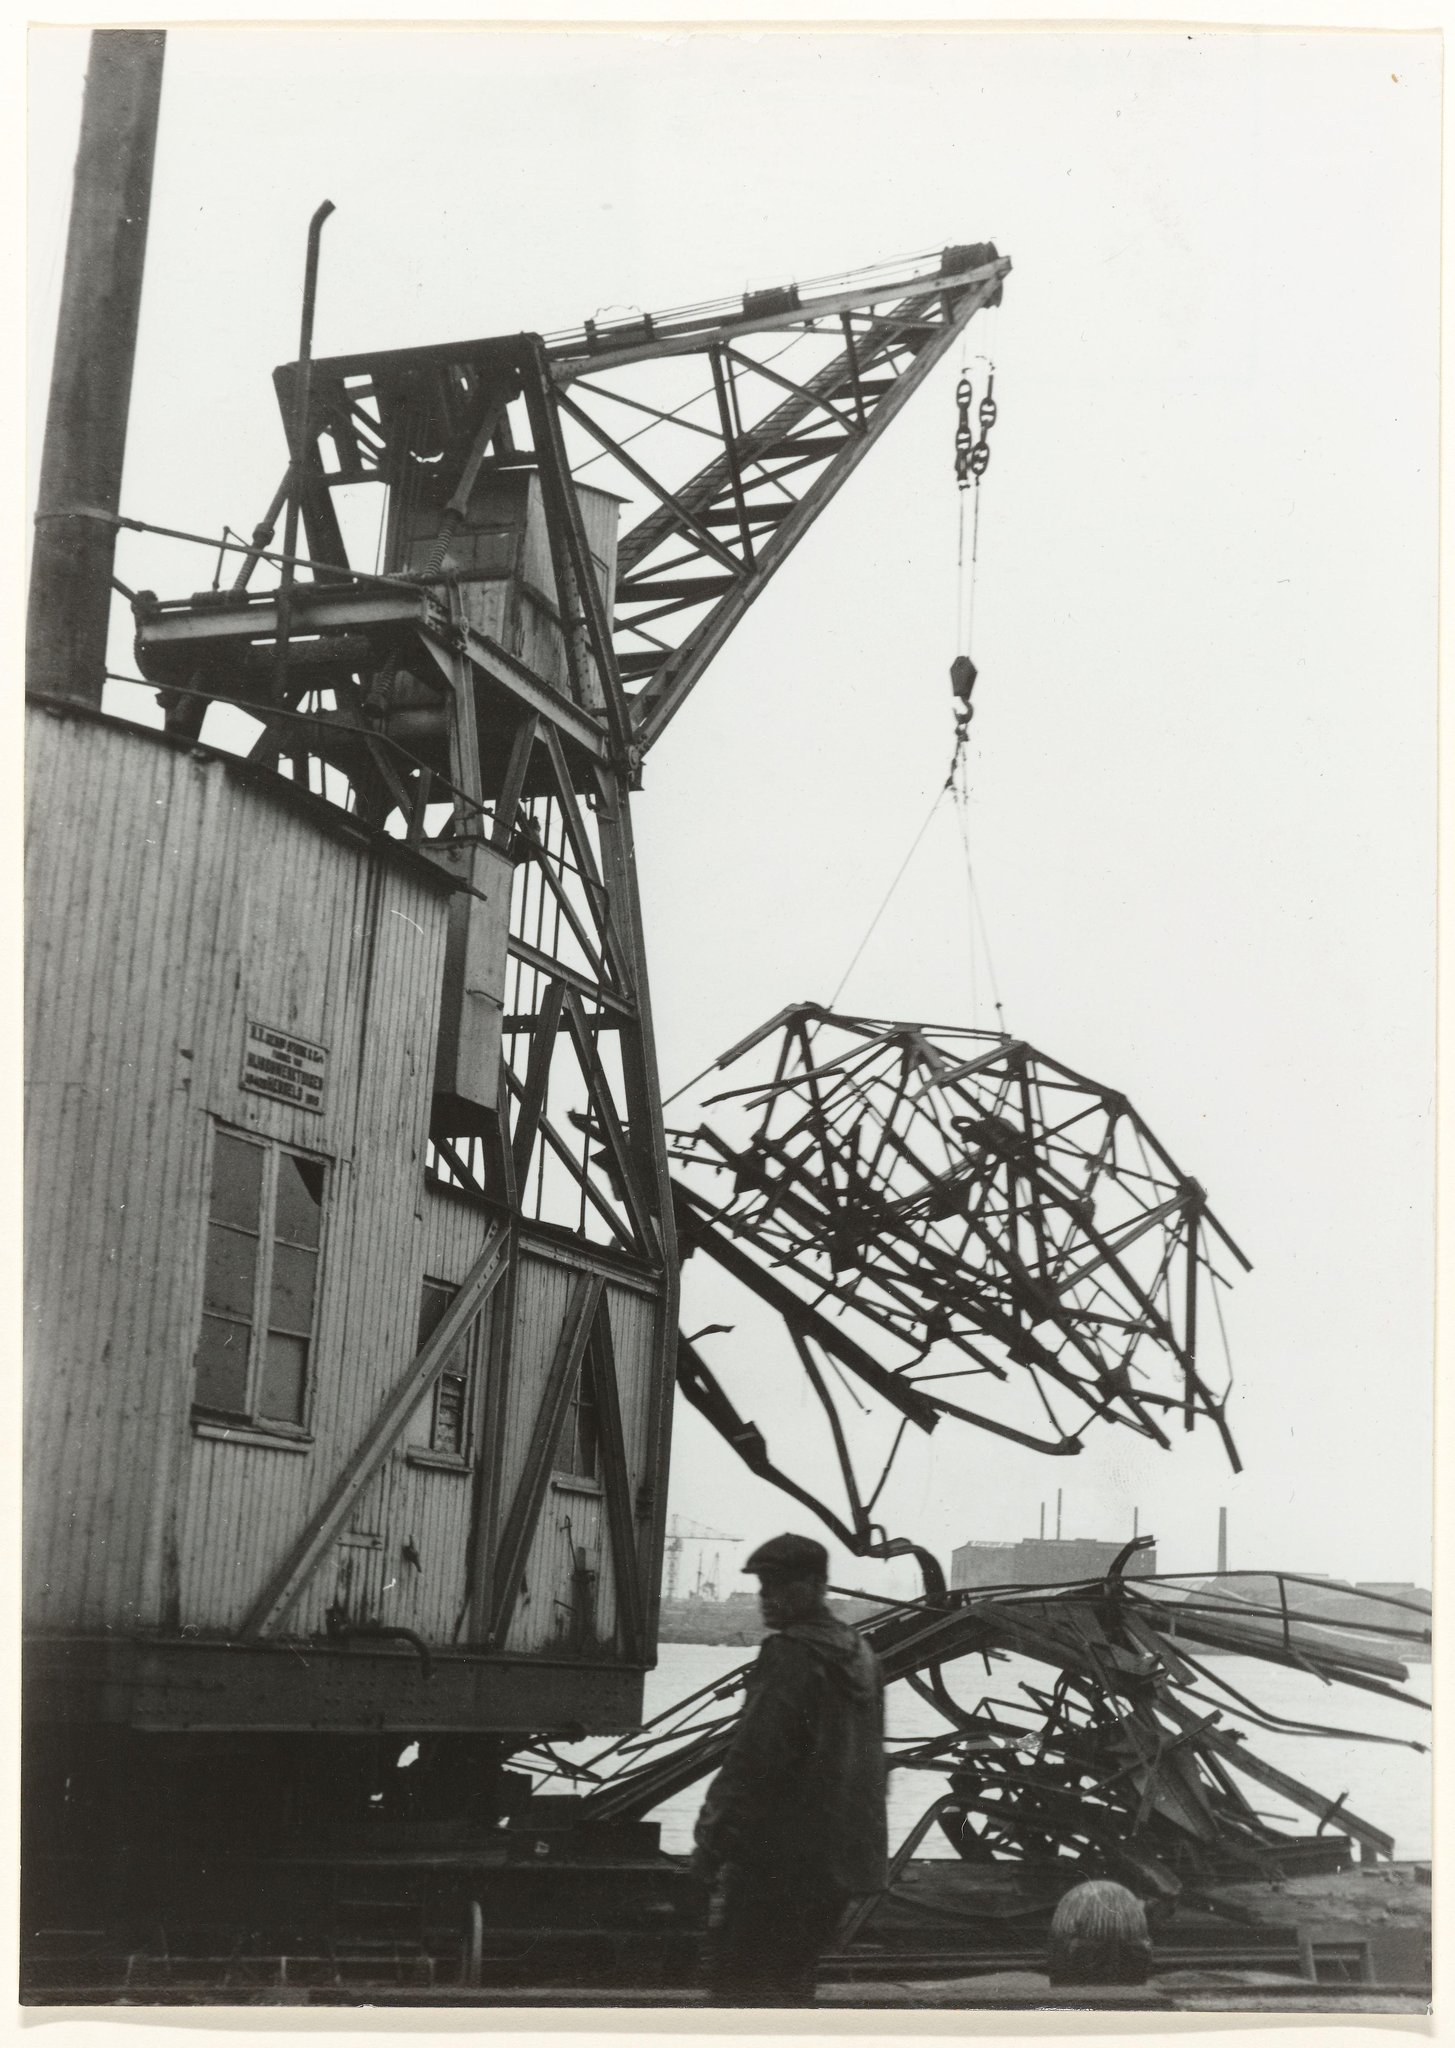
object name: photograph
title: Wederopbouw van de Amsterdamse haven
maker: charles breijer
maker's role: fotograaf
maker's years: 1914-2011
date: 1910-1945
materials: photographic support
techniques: photography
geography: amsterdam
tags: dock crane, amsterdam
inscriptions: stamp: ‘COPYRIGHT / 'ANEFO' / ALGEMEEN NEDERLANDSCH FOTOBUREAU’, inscription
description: Wederopbouw van de haven in Amsterdam, de opgeblazen kranen worden verwijderd.